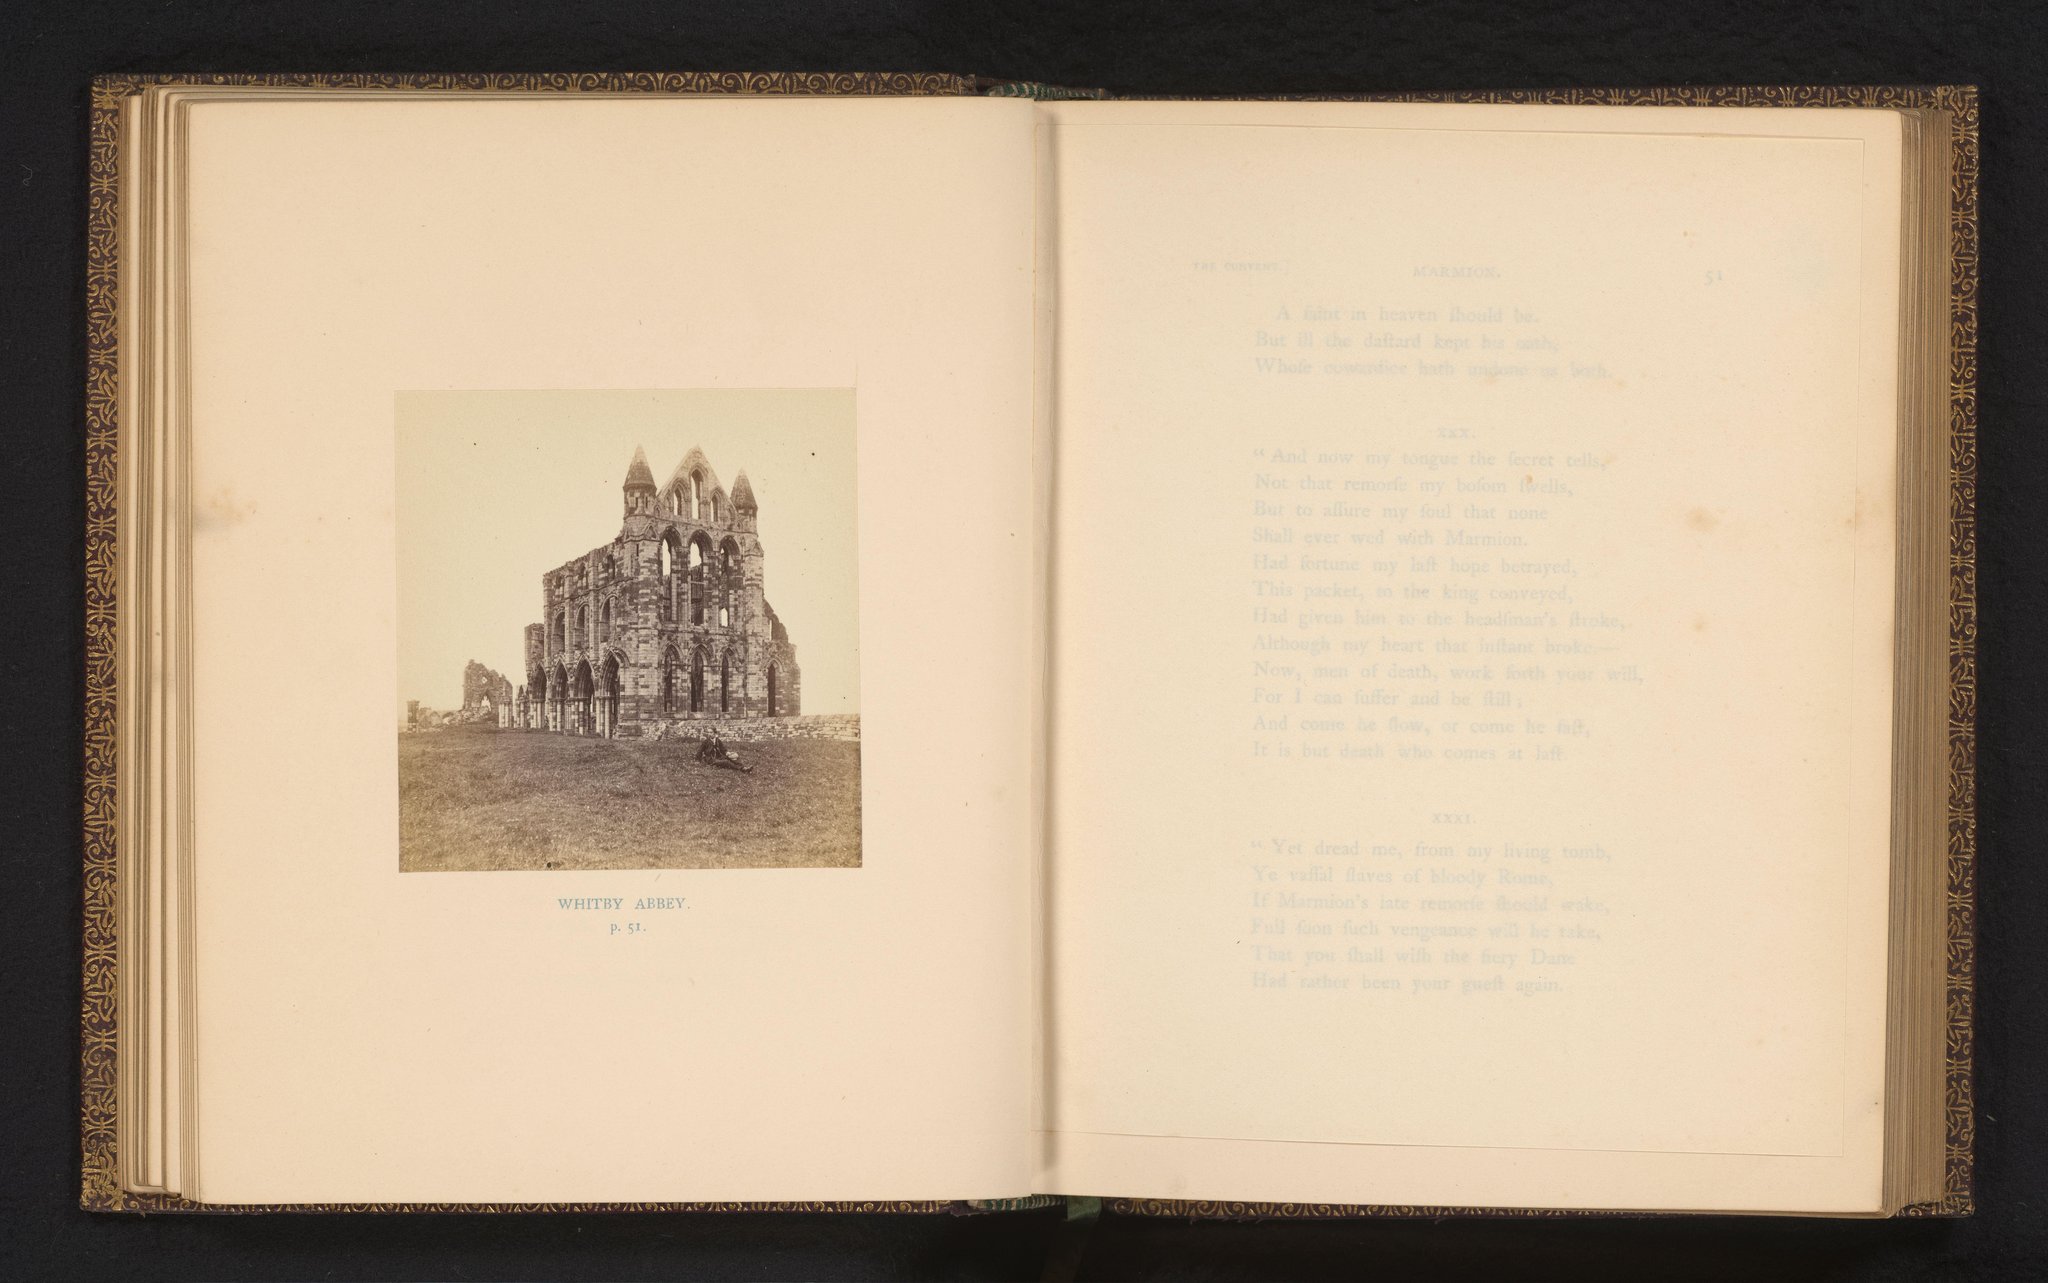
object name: page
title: Whitby Abbey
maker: thomas annan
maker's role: fotograaf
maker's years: 1829-1887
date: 1861-1866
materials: paper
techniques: albumen print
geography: whitby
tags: ruin of church, monastery, etc.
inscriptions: inscription: ‘p. 51.’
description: Foto op ongenummerde pagina tegenover pagina 51.